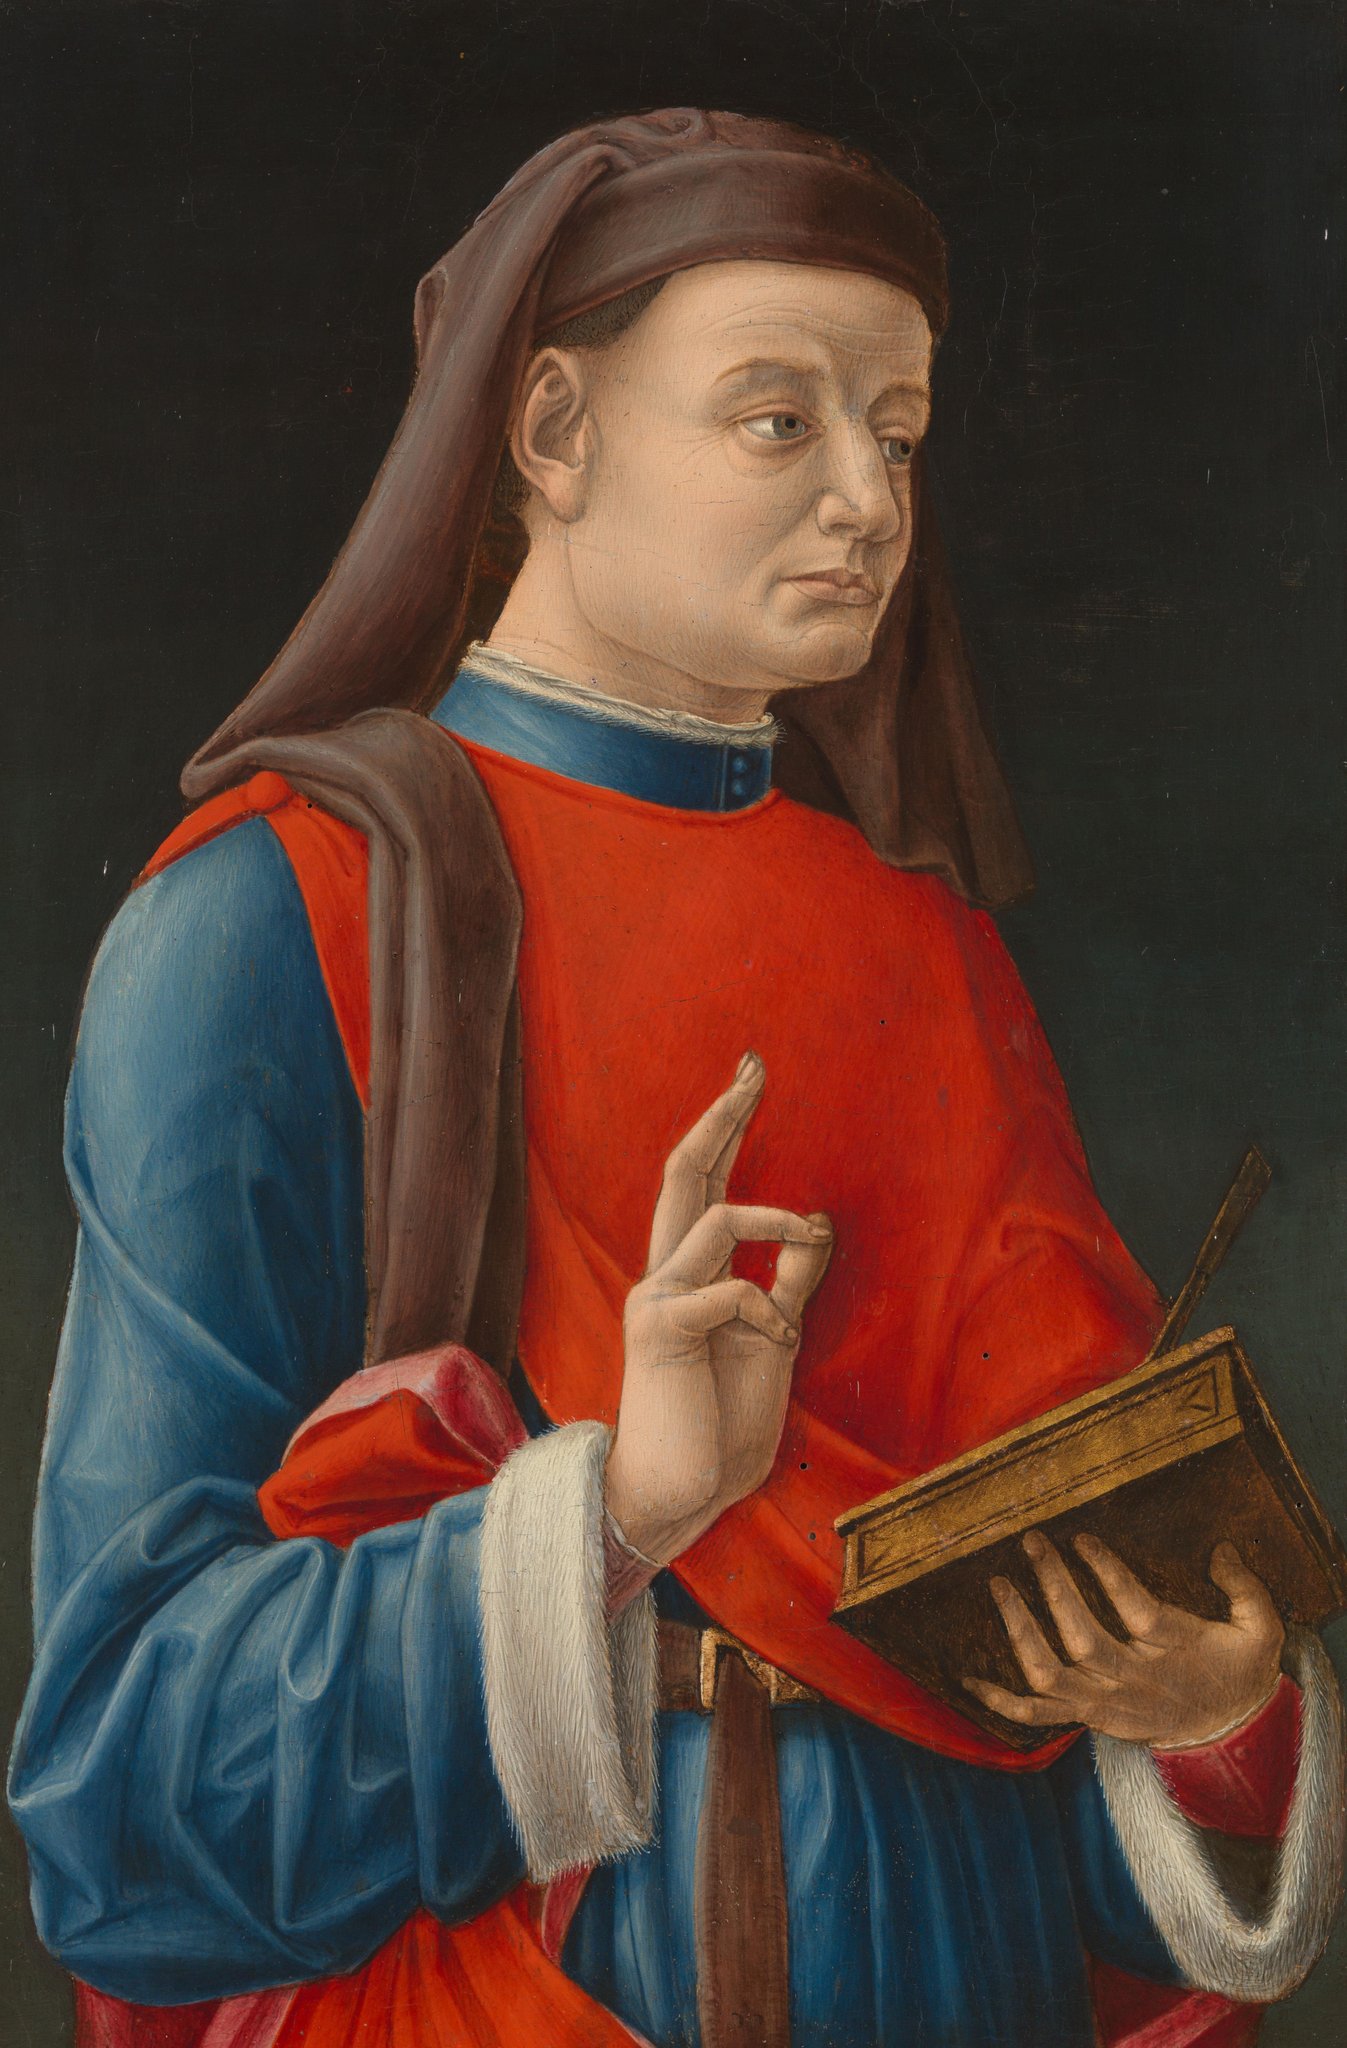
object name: painting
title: Saint Cosmas (or Damian)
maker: bartolommeo vivarini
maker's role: painter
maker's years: 1432-1499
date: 1460-1480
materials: panel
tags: the twin-brothers cosmas and damian(us), martyrs and physicians; possible attributes: box of ointment, cap, gown, lancet, pestle and mortar, urinal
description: Halffiguur van de heilige Cosmas (of misschien Damianus), in de hand een vierkante zalfdoos. Pendant van SK-A-4012.